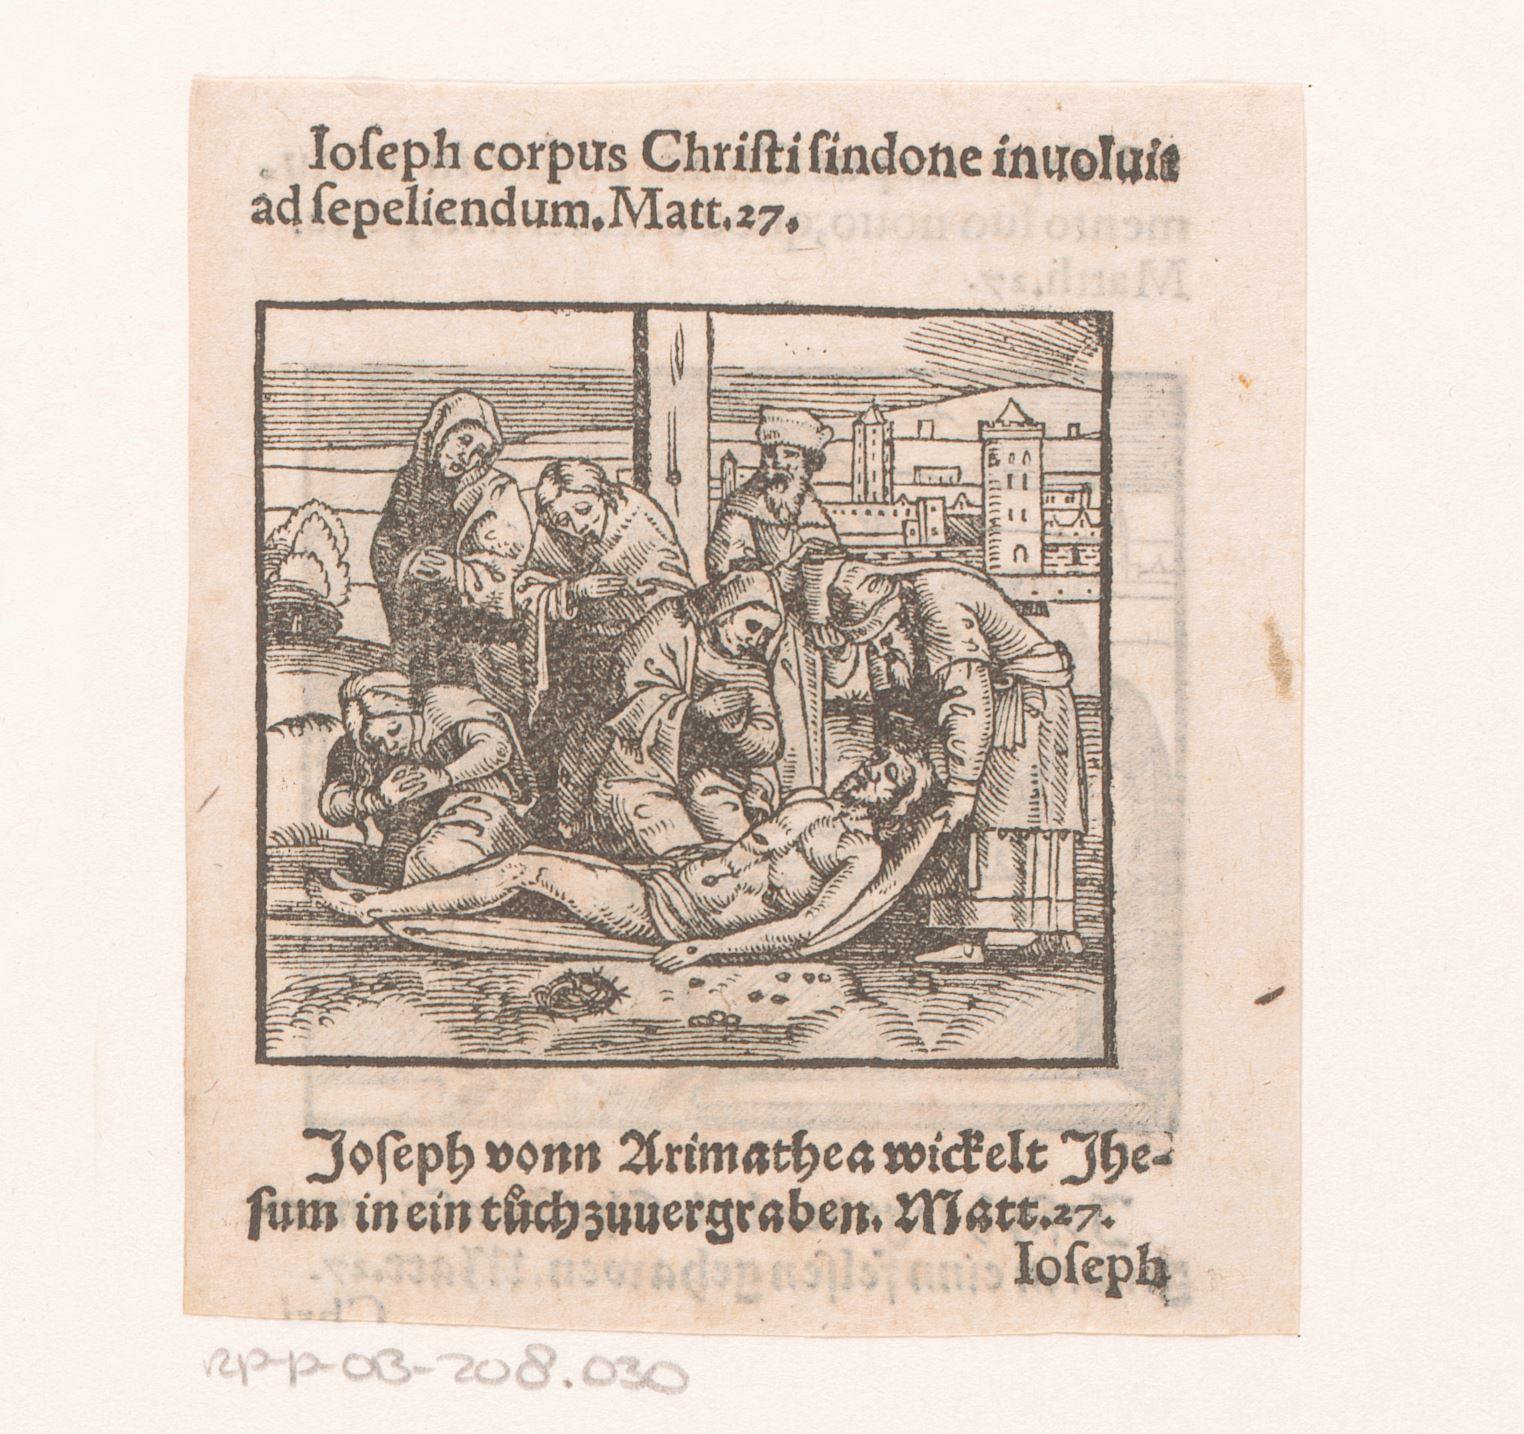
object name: print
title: Bewening van Christus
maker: Anonymous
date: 1600-1699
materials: paper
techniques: letterpress printing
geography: netherlands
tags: christ is laid down ~ descent from the cross, lamentation over the dead christ by his relatives and friends (christ usually without crown of thorns)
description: Christus is van het kruis gehaald en Maria, Johannes, Maria Magdalena en anderen bewenen hem. Nikodemus staat klaar om het lichaam te balsemen.